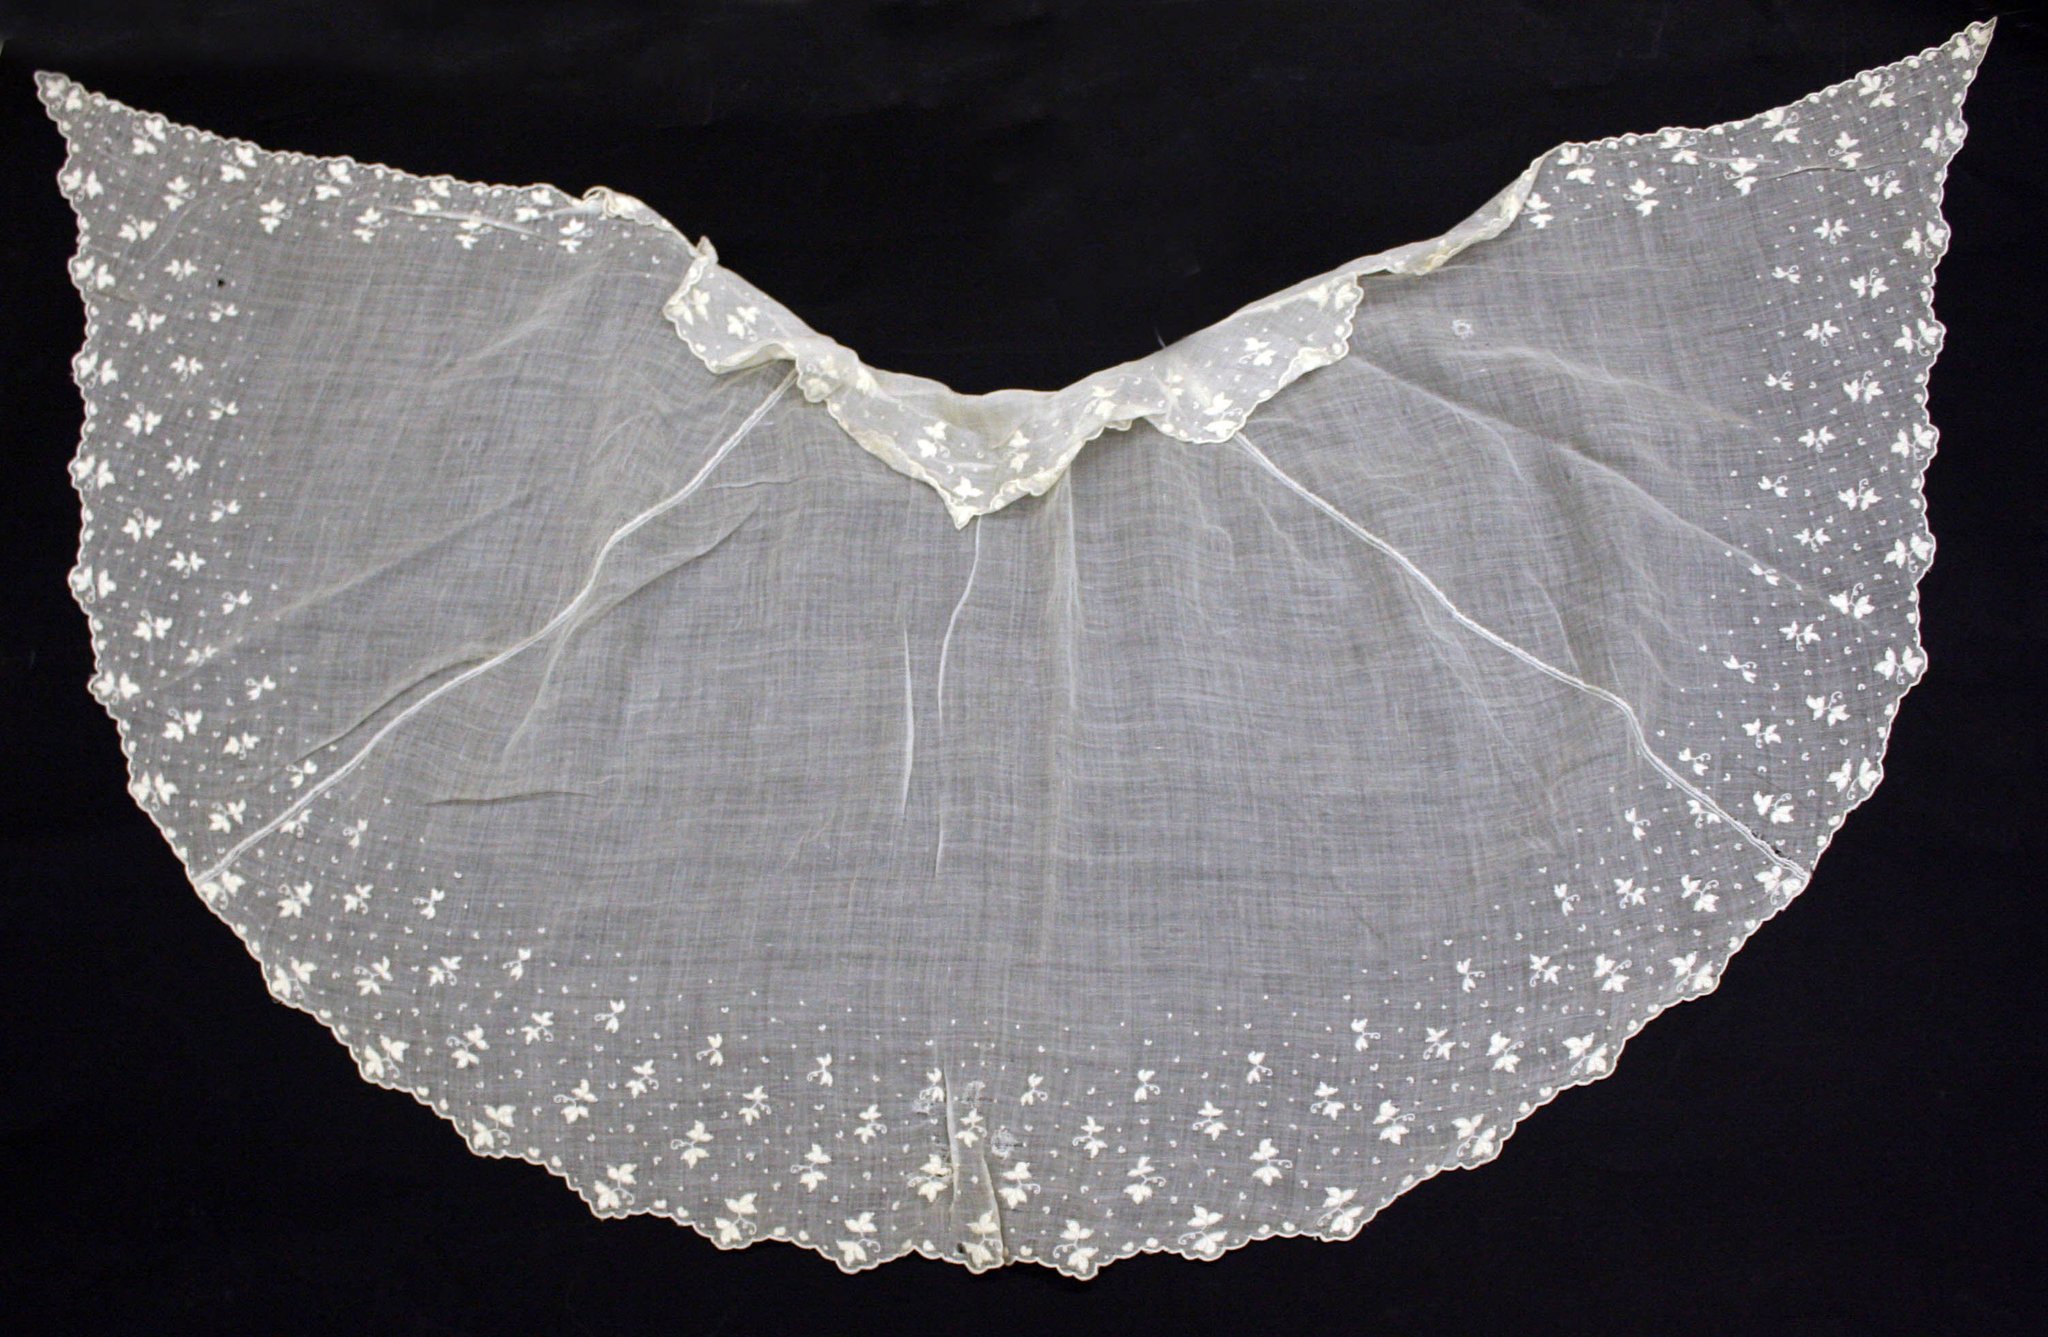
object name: fichu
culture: european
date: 1840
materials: cotton